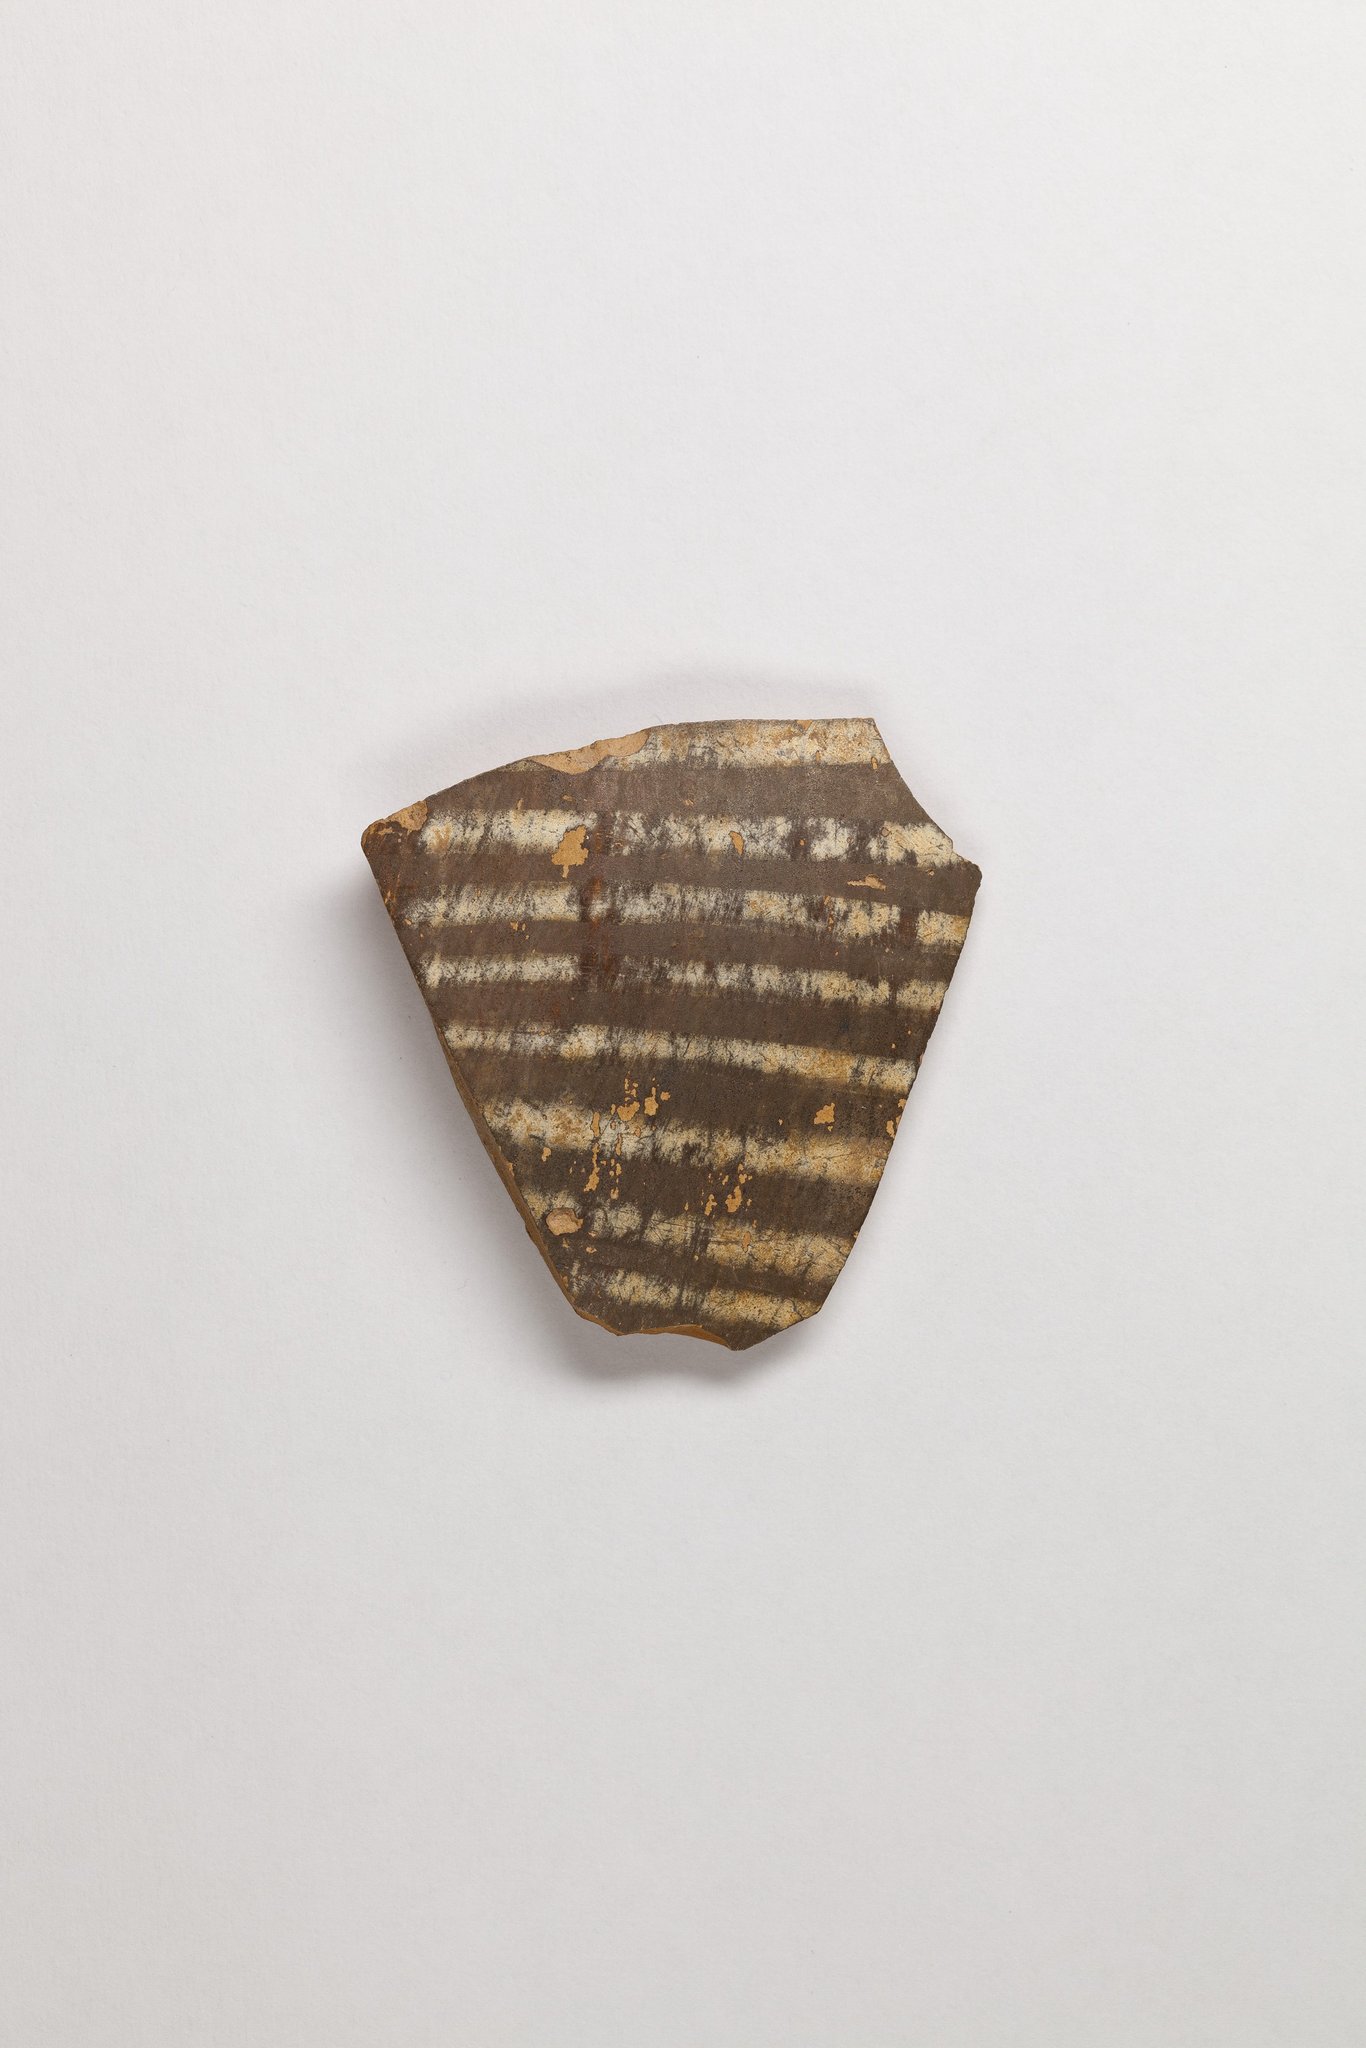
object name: minoan body sherd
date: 1981-1640 BCE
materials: pottery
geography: egypt